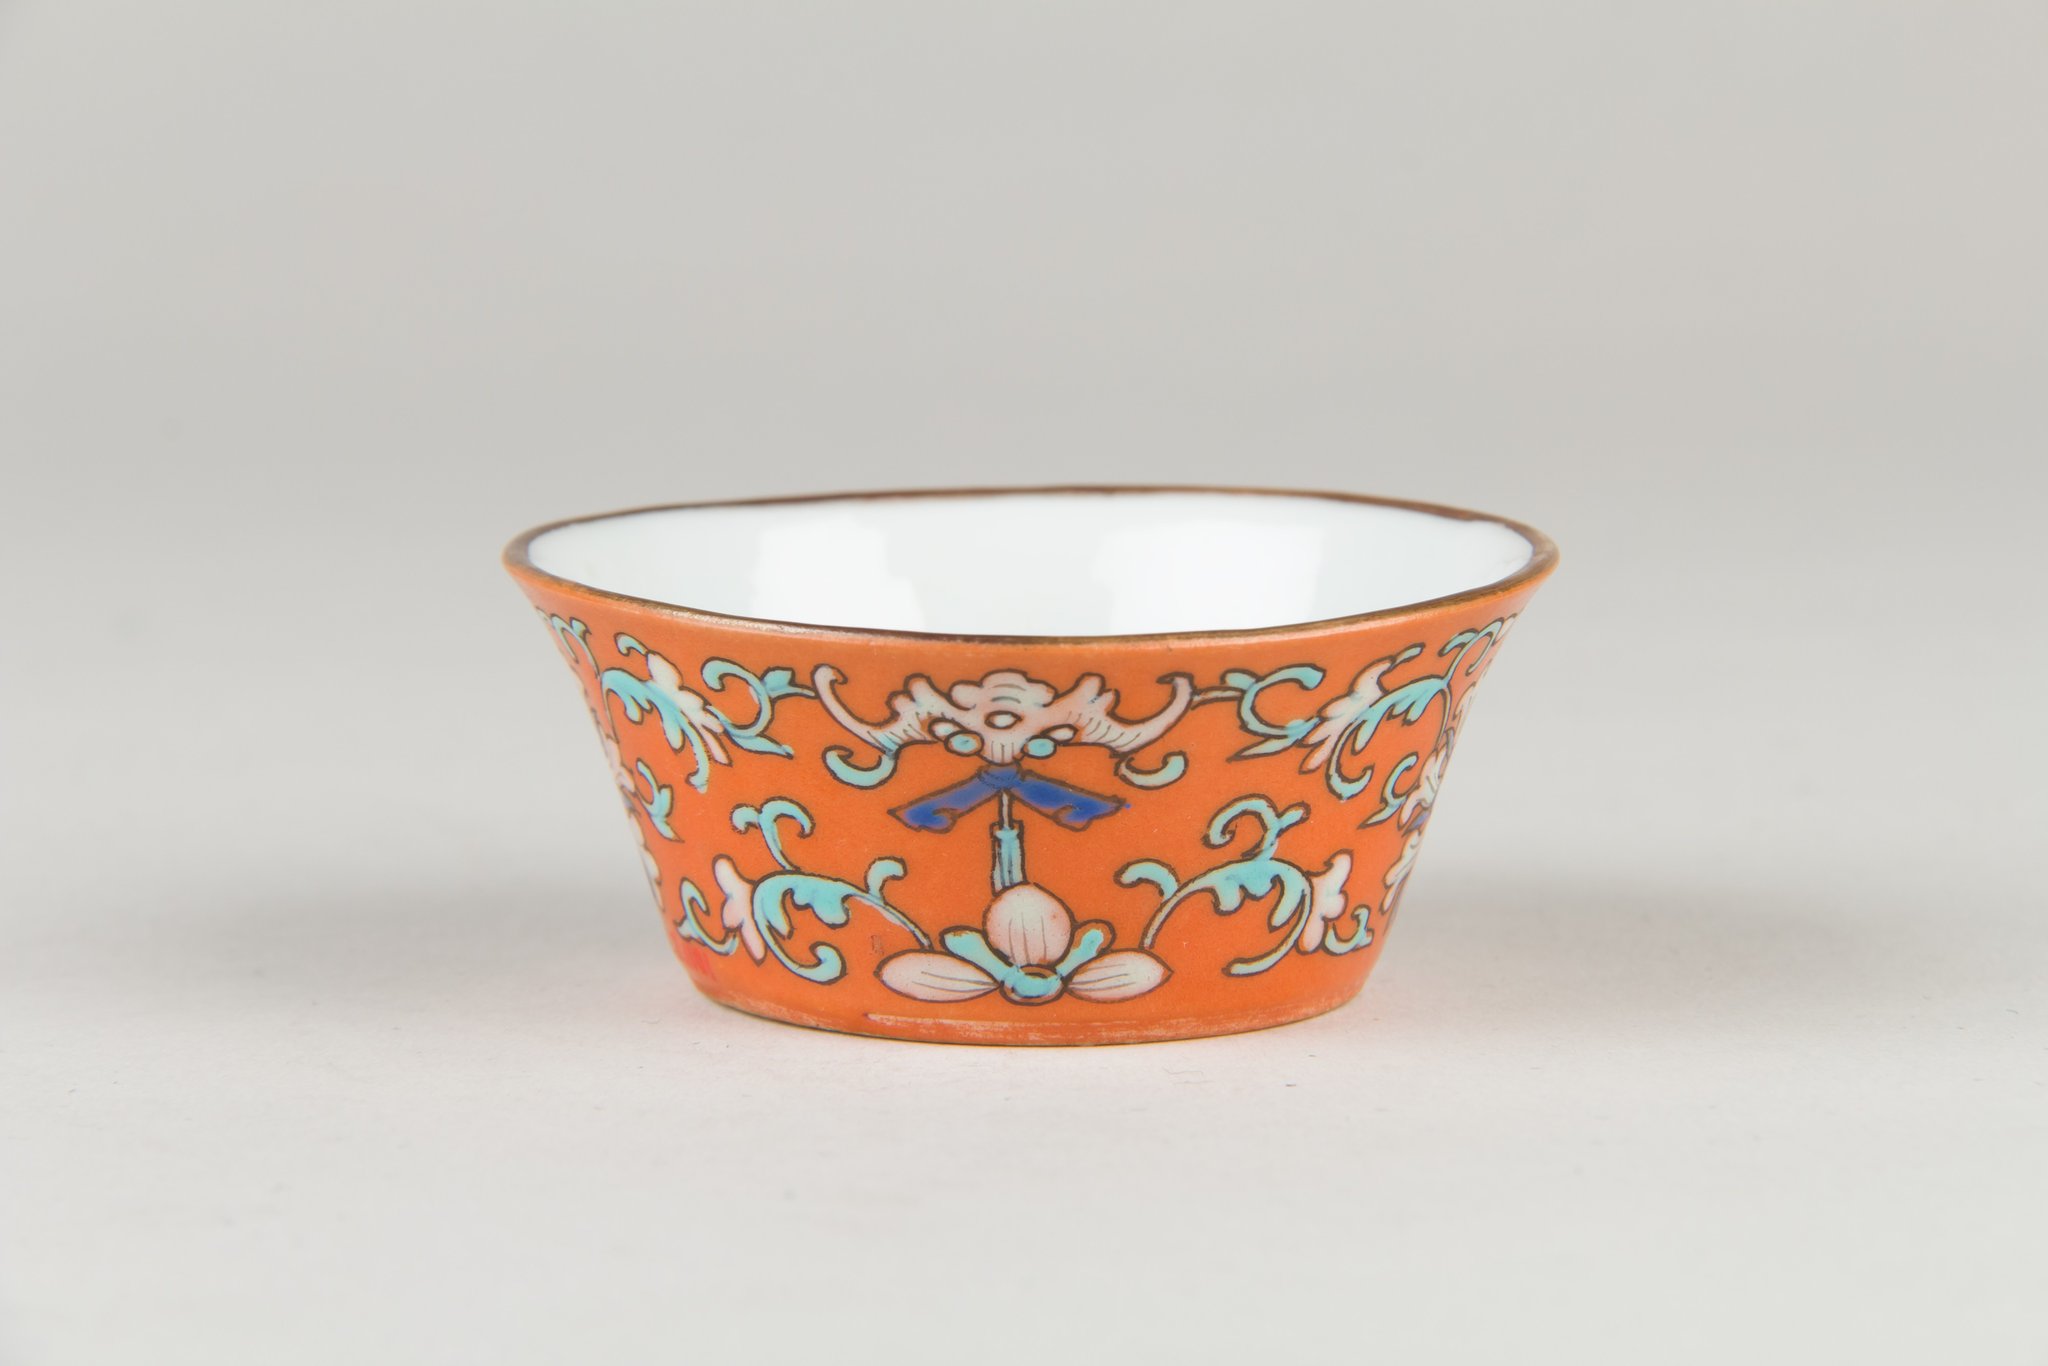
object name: cup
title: Cup (from a set of eight)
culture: chinese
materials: enamel, glaze, iron, porcelain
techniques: overglaze, painting, polychrome